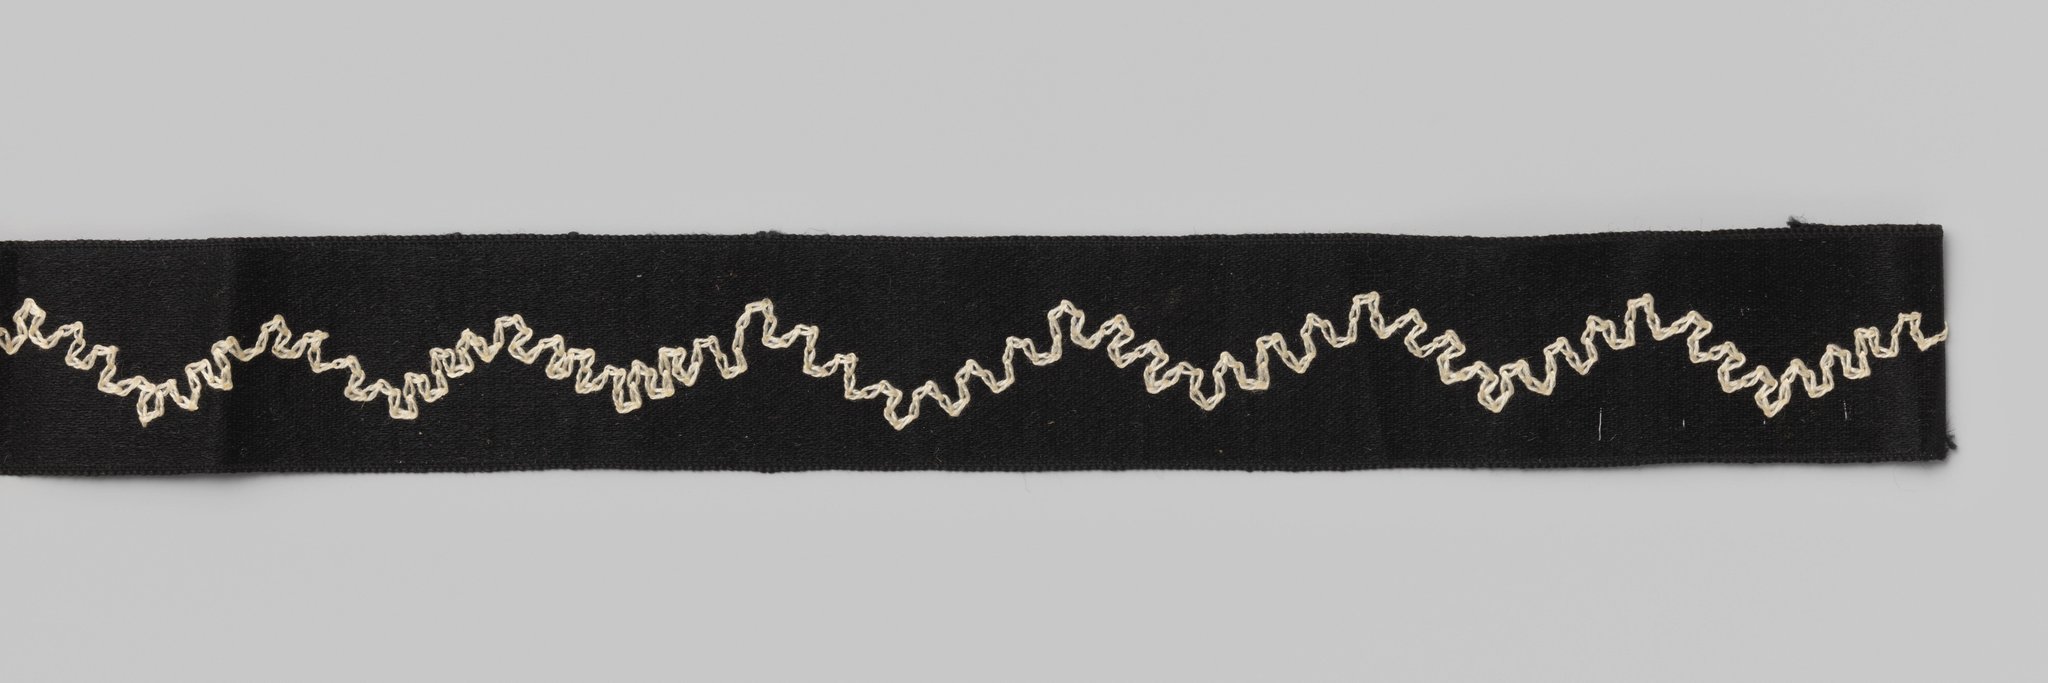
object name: rol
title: Rol zwart satijnlint met wit golvend geborduurd motief op karton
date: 1900-1925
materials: cardboard, textile, silk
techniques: embroidered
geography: nijmegen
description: Rol zwart satijnlint met wit golvend geborduurd motief op karton.